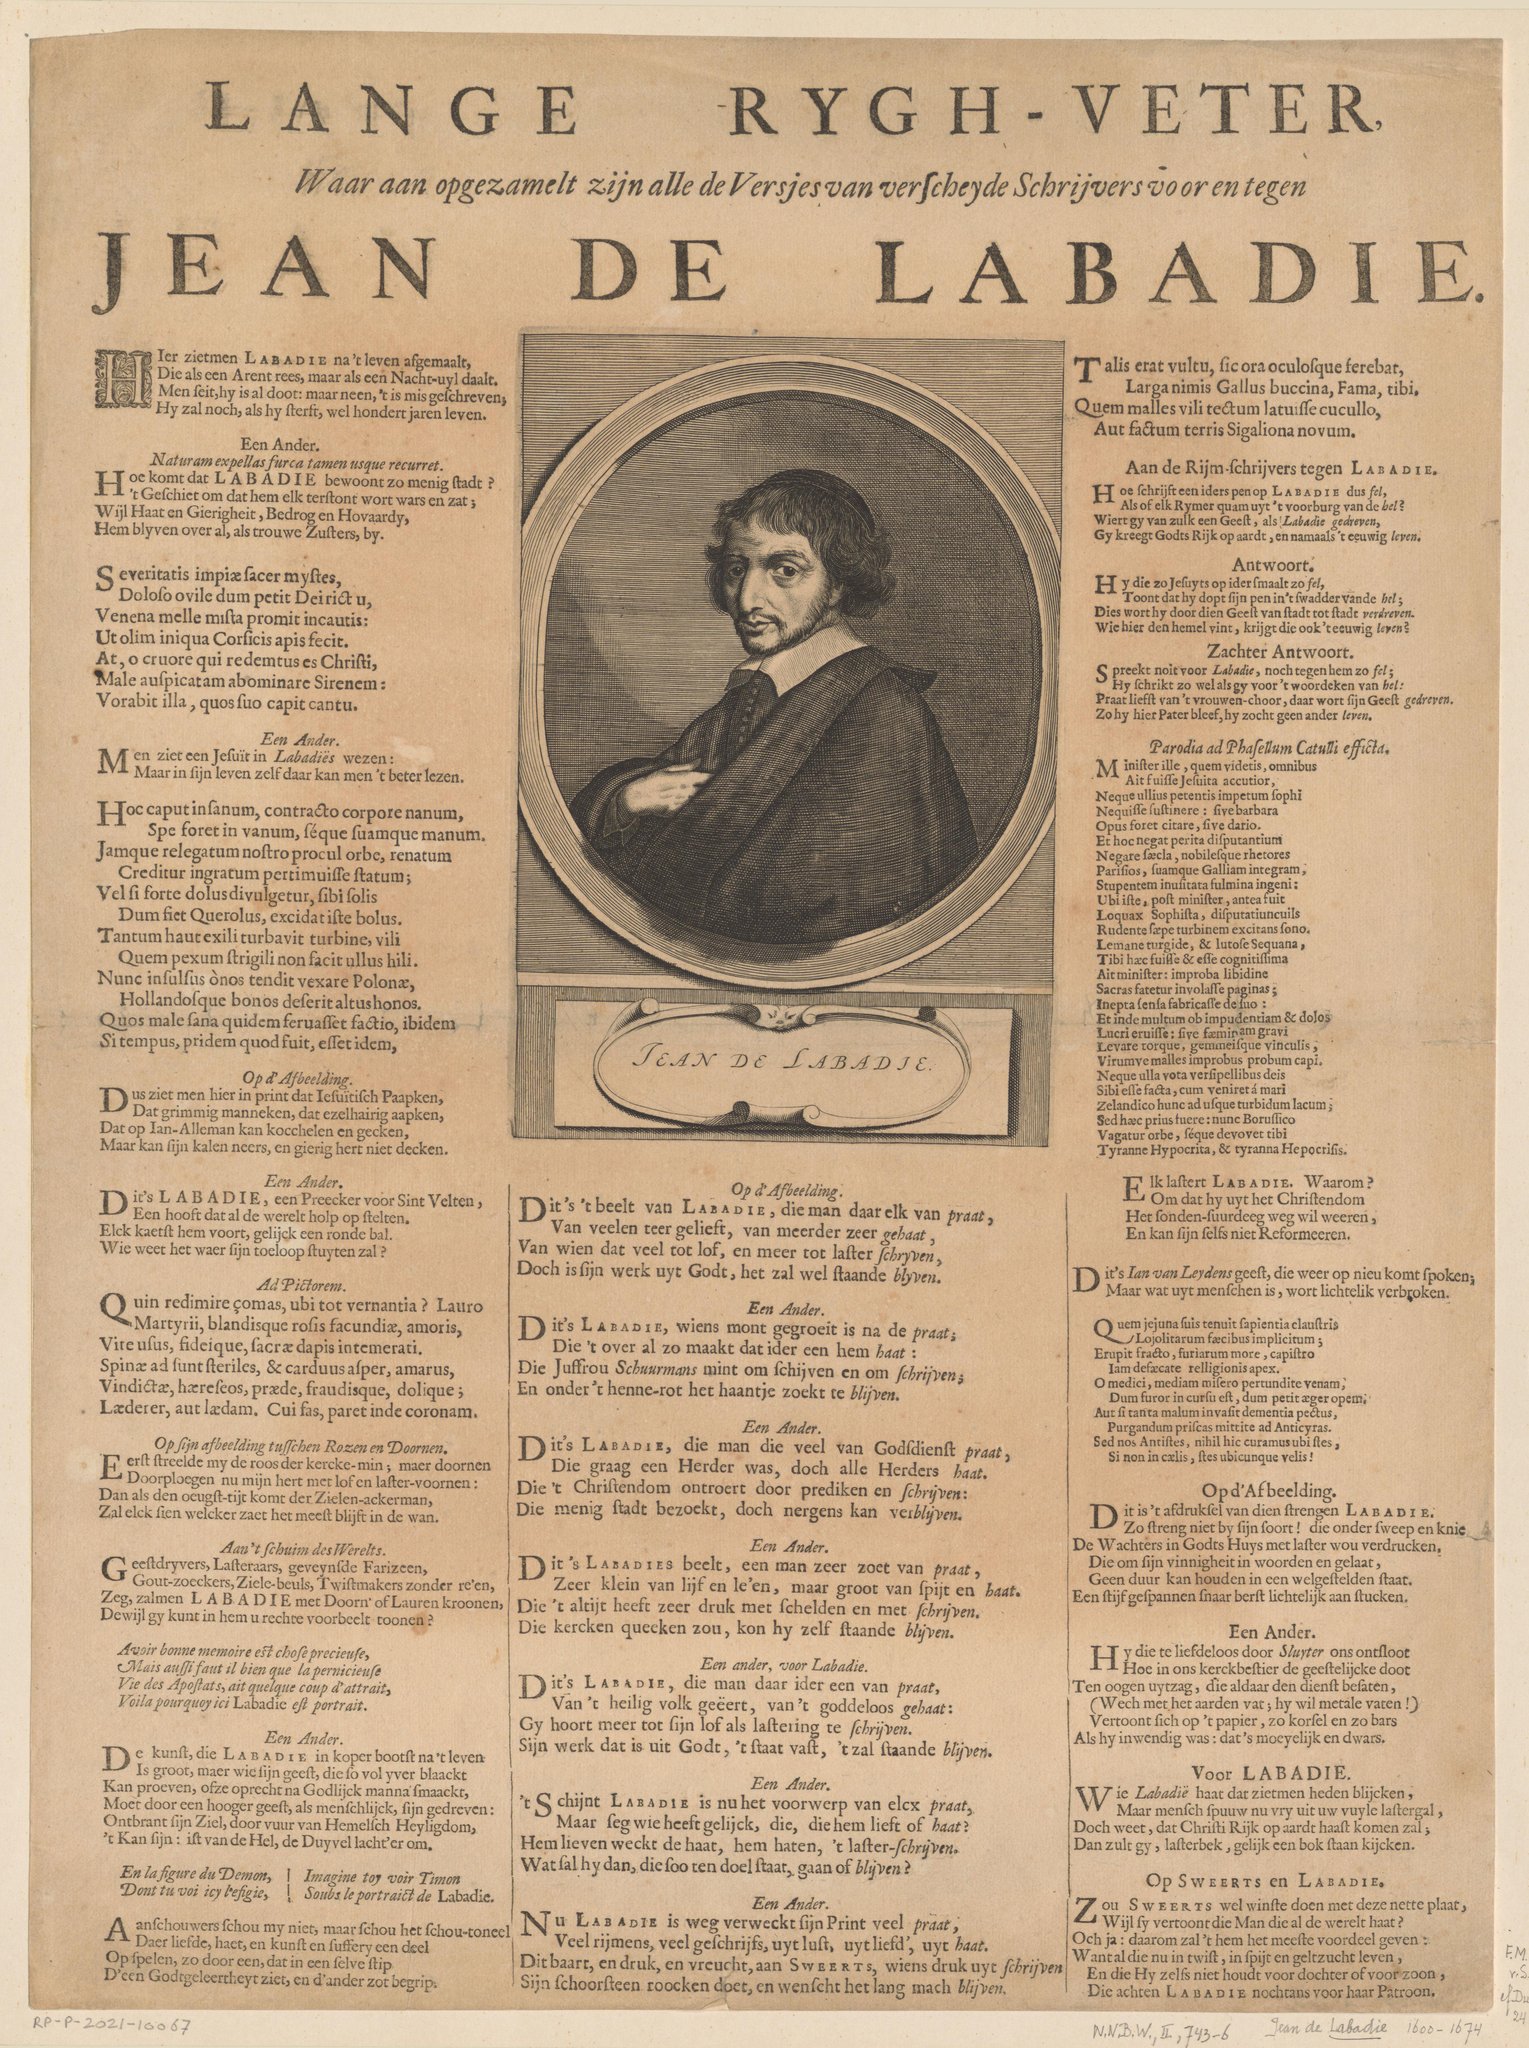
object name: text sheet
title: Lange rygh-veter, waar aan opgezamelt zijn alle de versjes van verscheyde schrijvers voor en tegen Jean de Labadie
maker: Anonymous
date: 1650-1699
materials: paper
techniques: engraving, letterpress printing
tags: historical persons